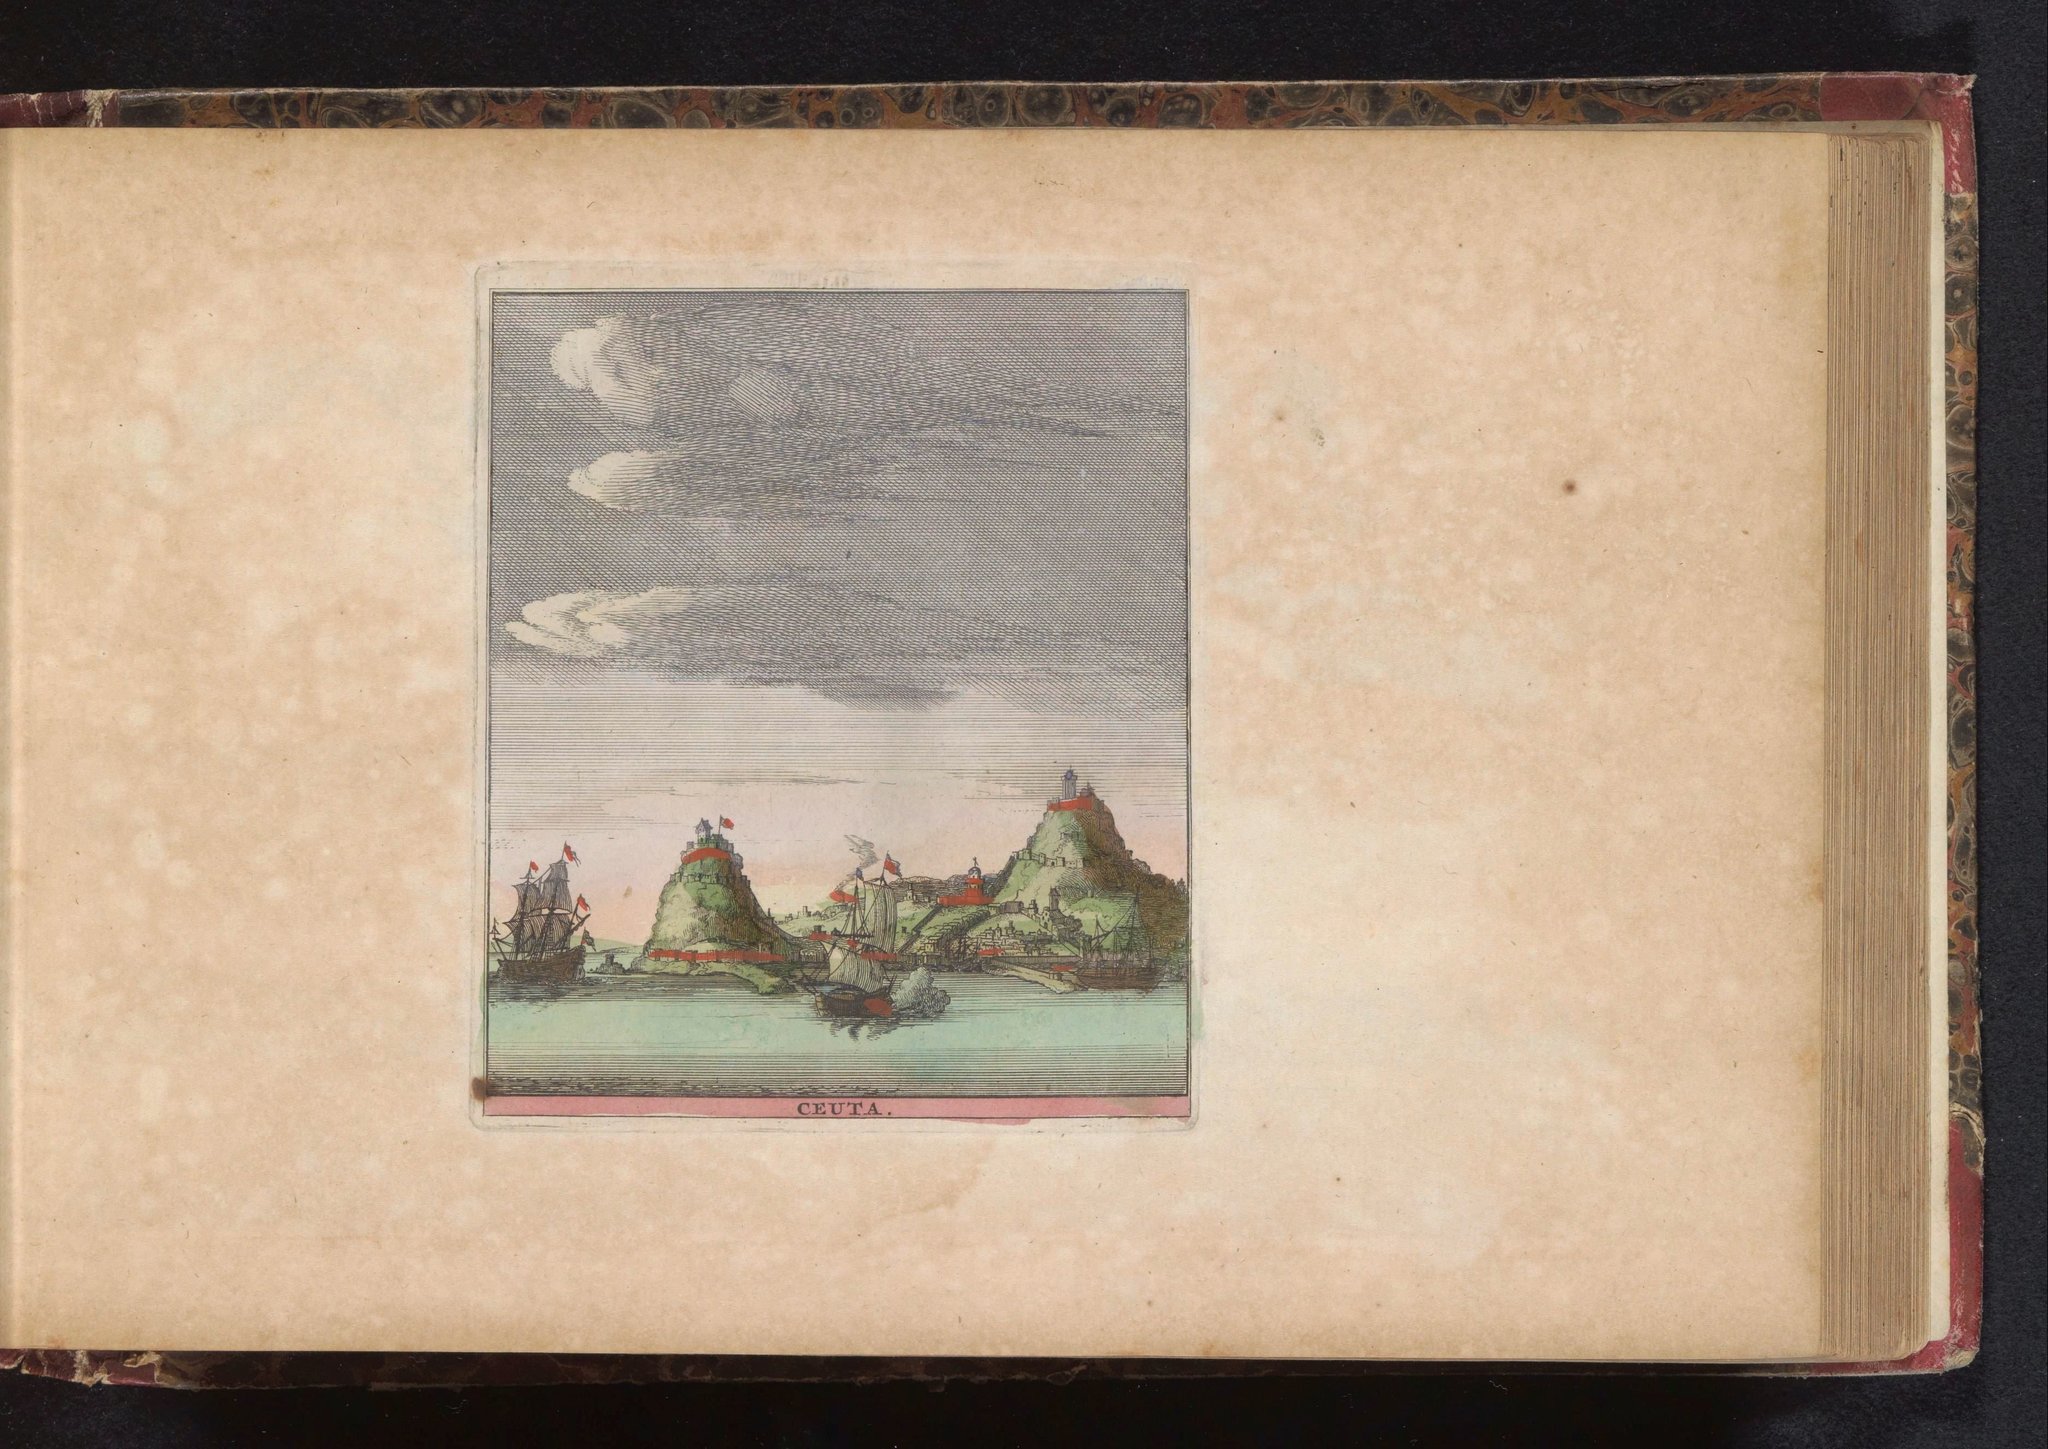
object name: print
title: Ceuta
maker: Anonymous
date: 1735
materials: paper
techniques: etching, hand coloring, lacquer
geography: northern netherlands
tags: maps of cities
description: Gezicht op Ceuta, Spaanse enclave in Marokko. Onderdeel van een atlas met 223 kaarten van landen en steden en oorlogstaferelen in Europa in de periode ca. 1690-1735.